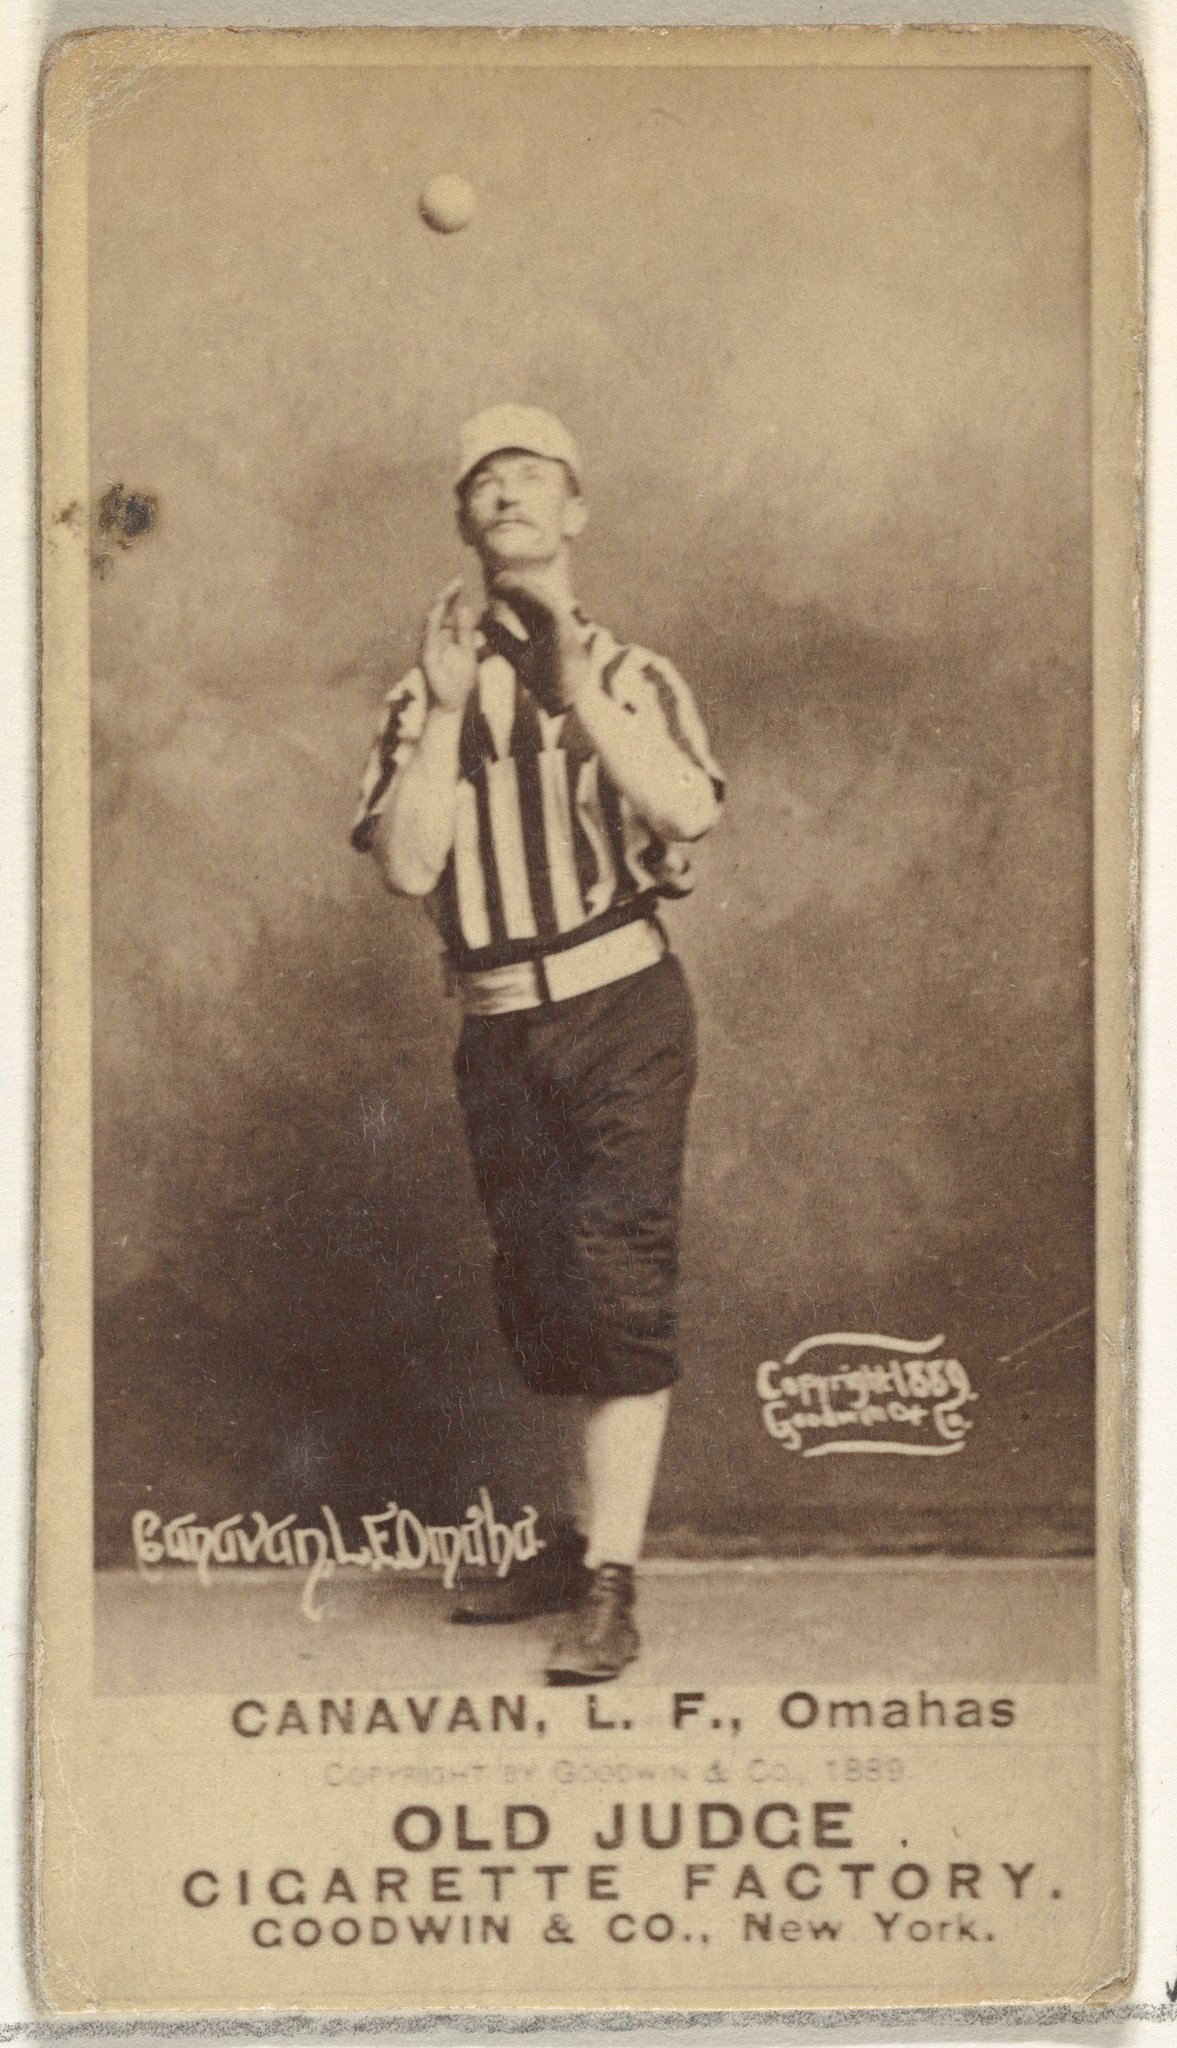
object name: baseball card, photograph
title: James Edward "Jim" Canavan, Left Field, Omaha Omahogs/ Lambs, from the Old Judge series (N172) for Old Judge Cigarettes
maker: goodwin & company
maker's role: publisher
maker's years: 1850-1950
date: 1889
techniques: albumen silver print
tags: men,portraits,baseball,athletes